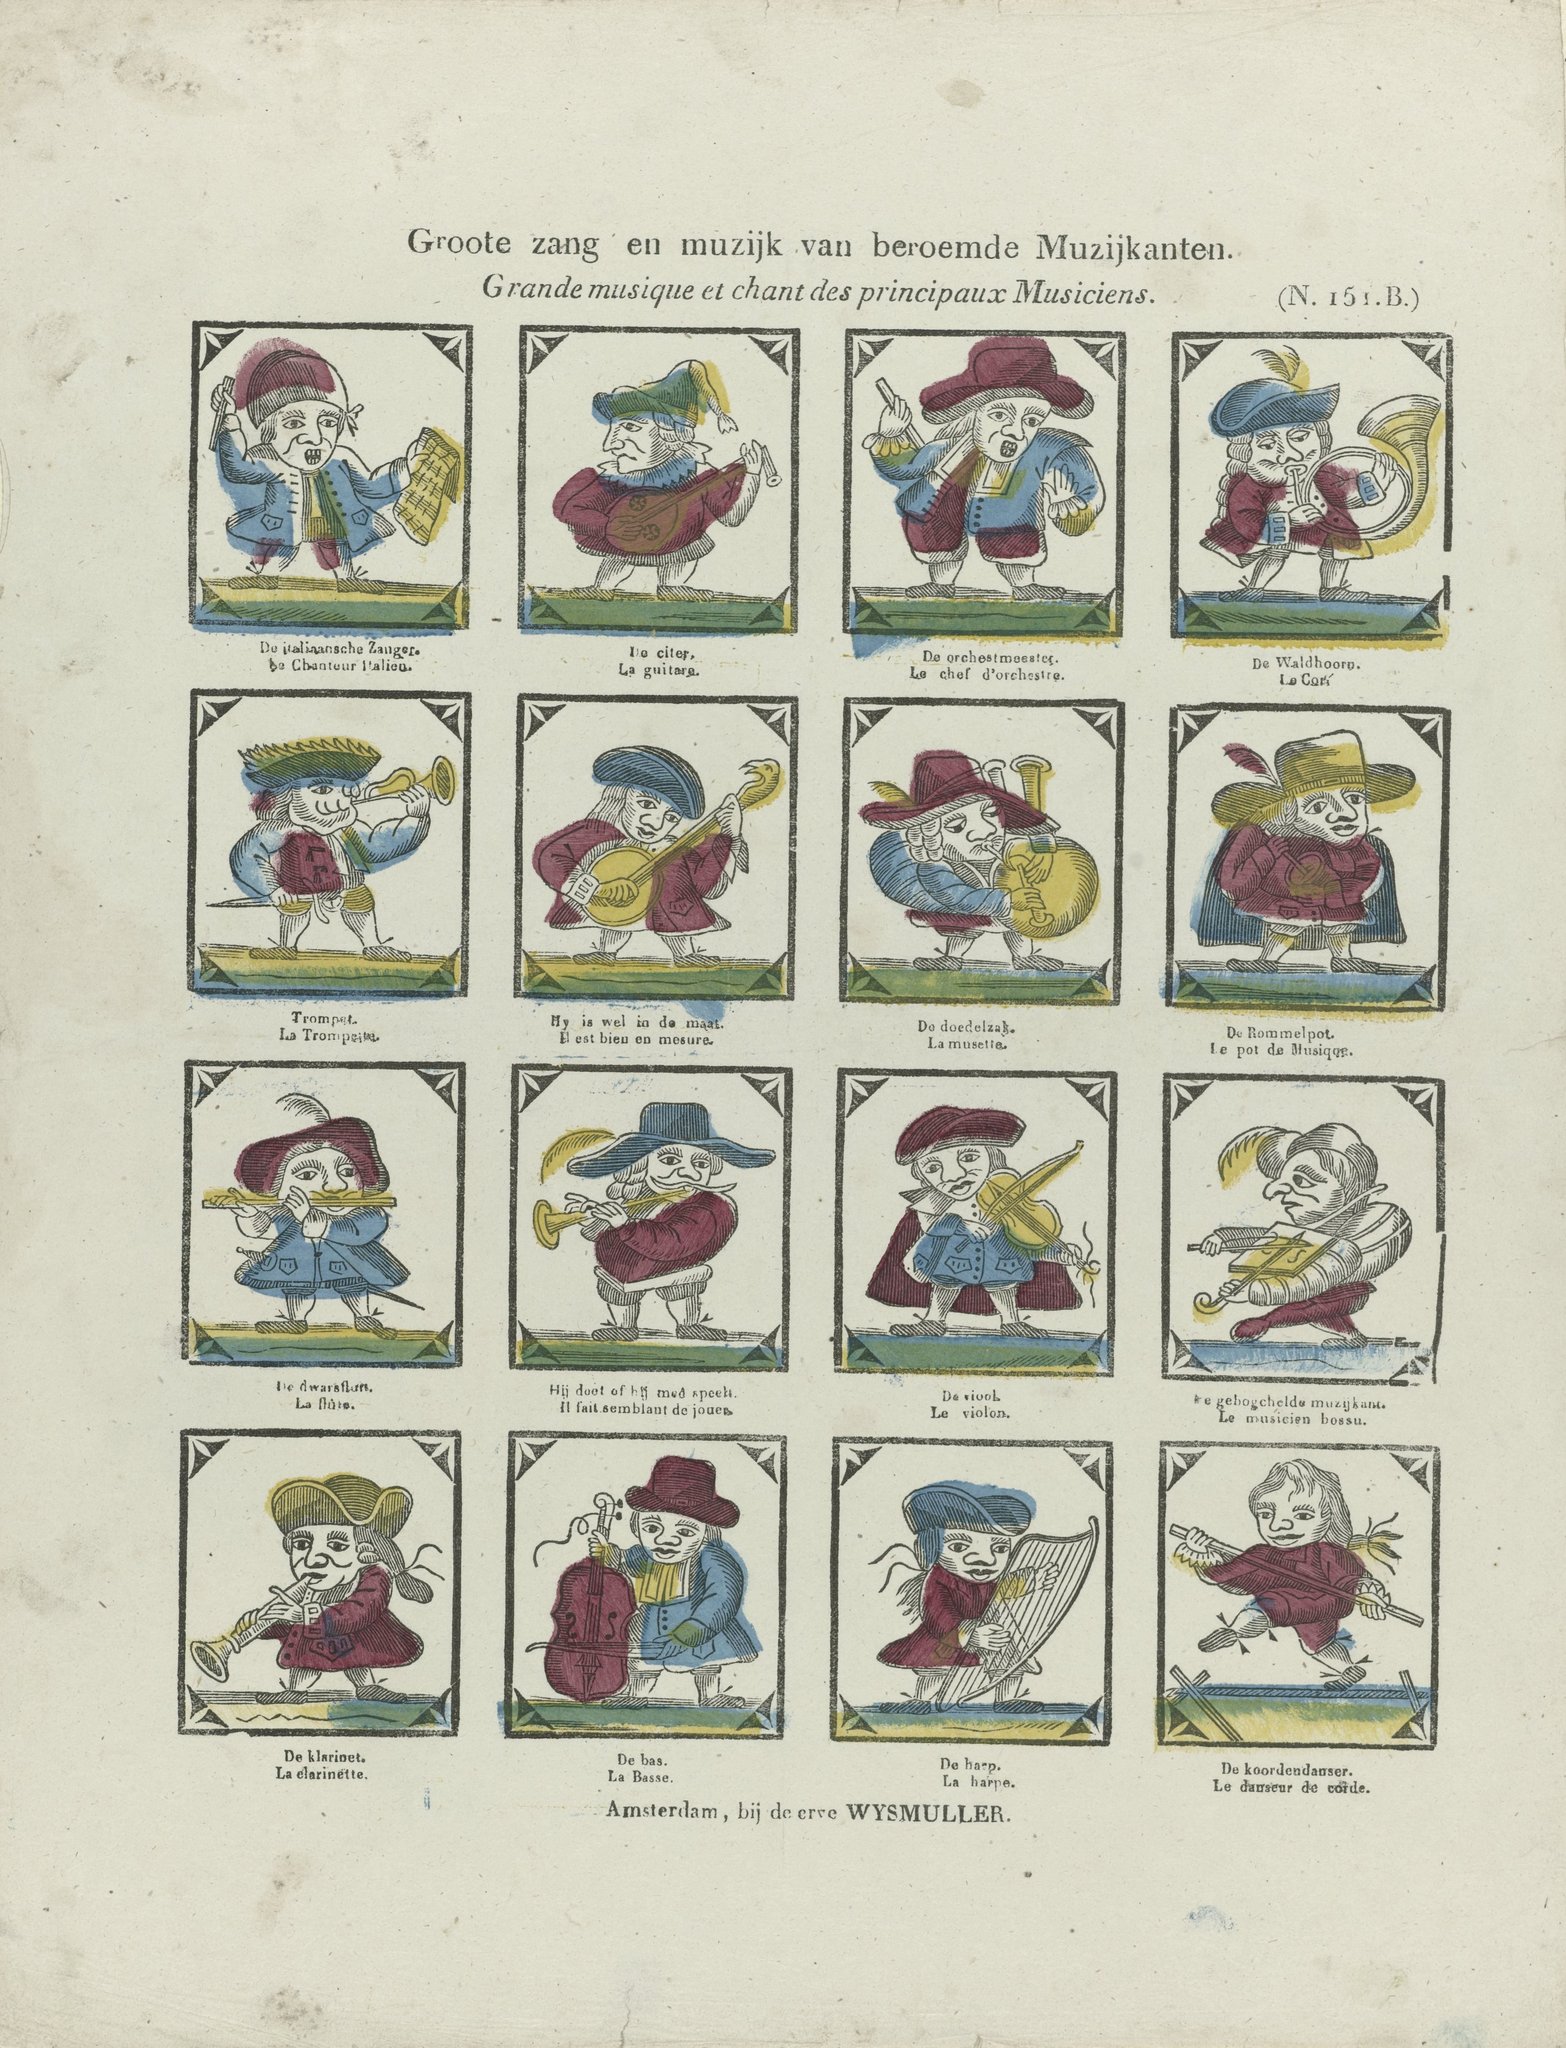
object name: print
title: Groote zang en muzijk van beroemde muzijkanten / Grande musique et chants des principaux musiciens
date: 1828-1913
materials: paper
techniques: colour, letterpress printing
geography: turnhout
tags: musician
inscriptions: collector's mark: Lugt 2760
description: Blad met 16 voorstellingen van muzikanten. Onder elke afbeelding een onderschrift in het Nederlands en in het Frans. Genummerd rechtsboven: (No. 151. B.).